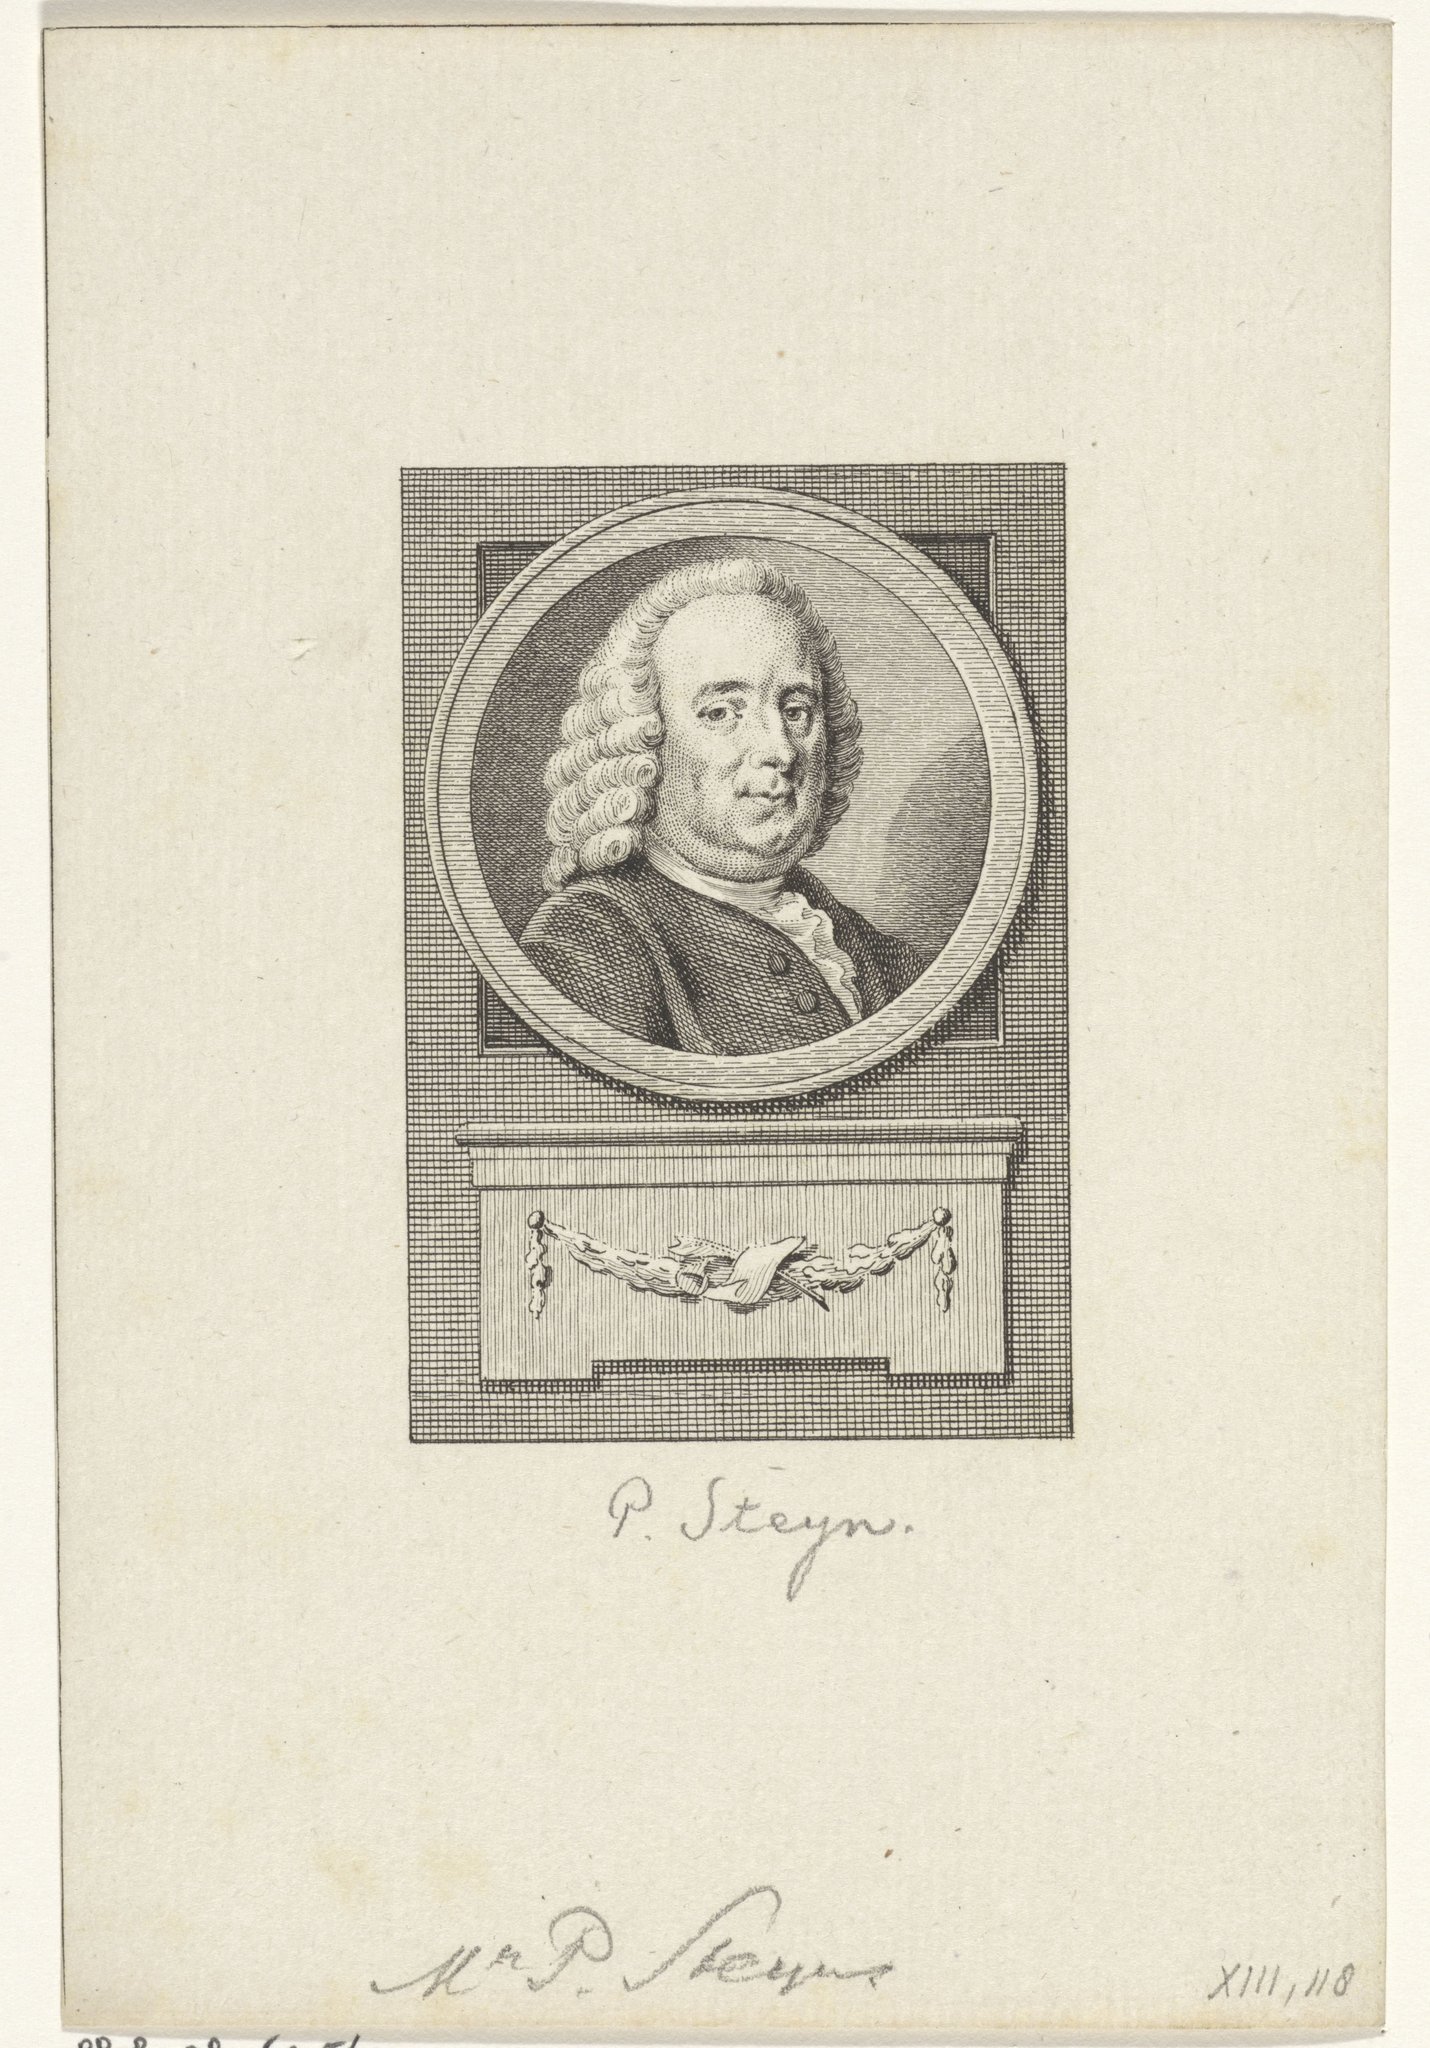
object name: print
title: Portret van Pieter Steijn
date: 1783-1795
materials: paper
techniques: engraving, etching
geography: amsterdam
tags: haarlem, the hague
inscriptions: collector's mark: Lugt 2228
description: Latere staat prent gebruikt in: Fokke, Jan. Geschiedenissen der Vereenigde Nederlanden voor de vaderlandsche jeugd Ie-XXVste deel. Amsterdam: Johannes Allart, 1783-1795. Deel XIII.